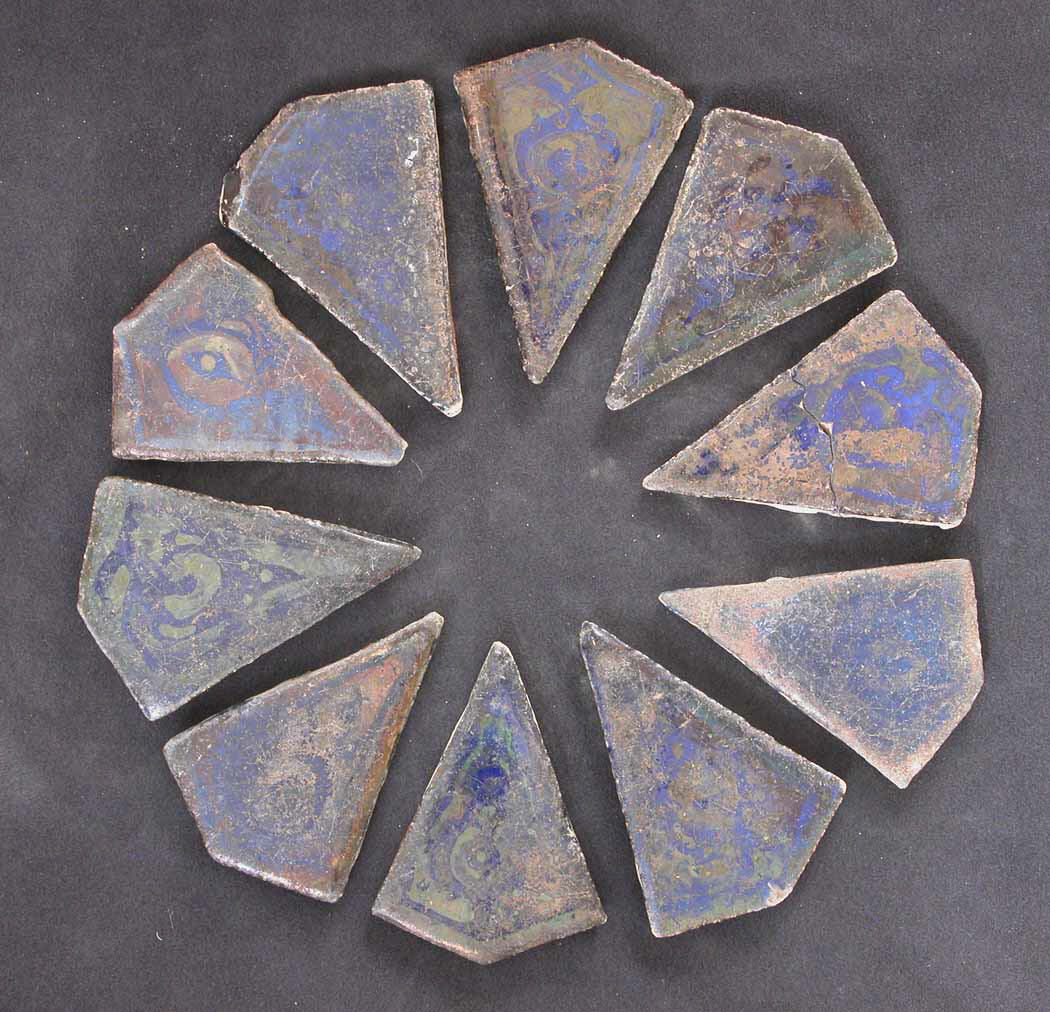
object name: tile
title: Tiles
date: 1134-1166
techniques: glazing, luster painting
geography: syria